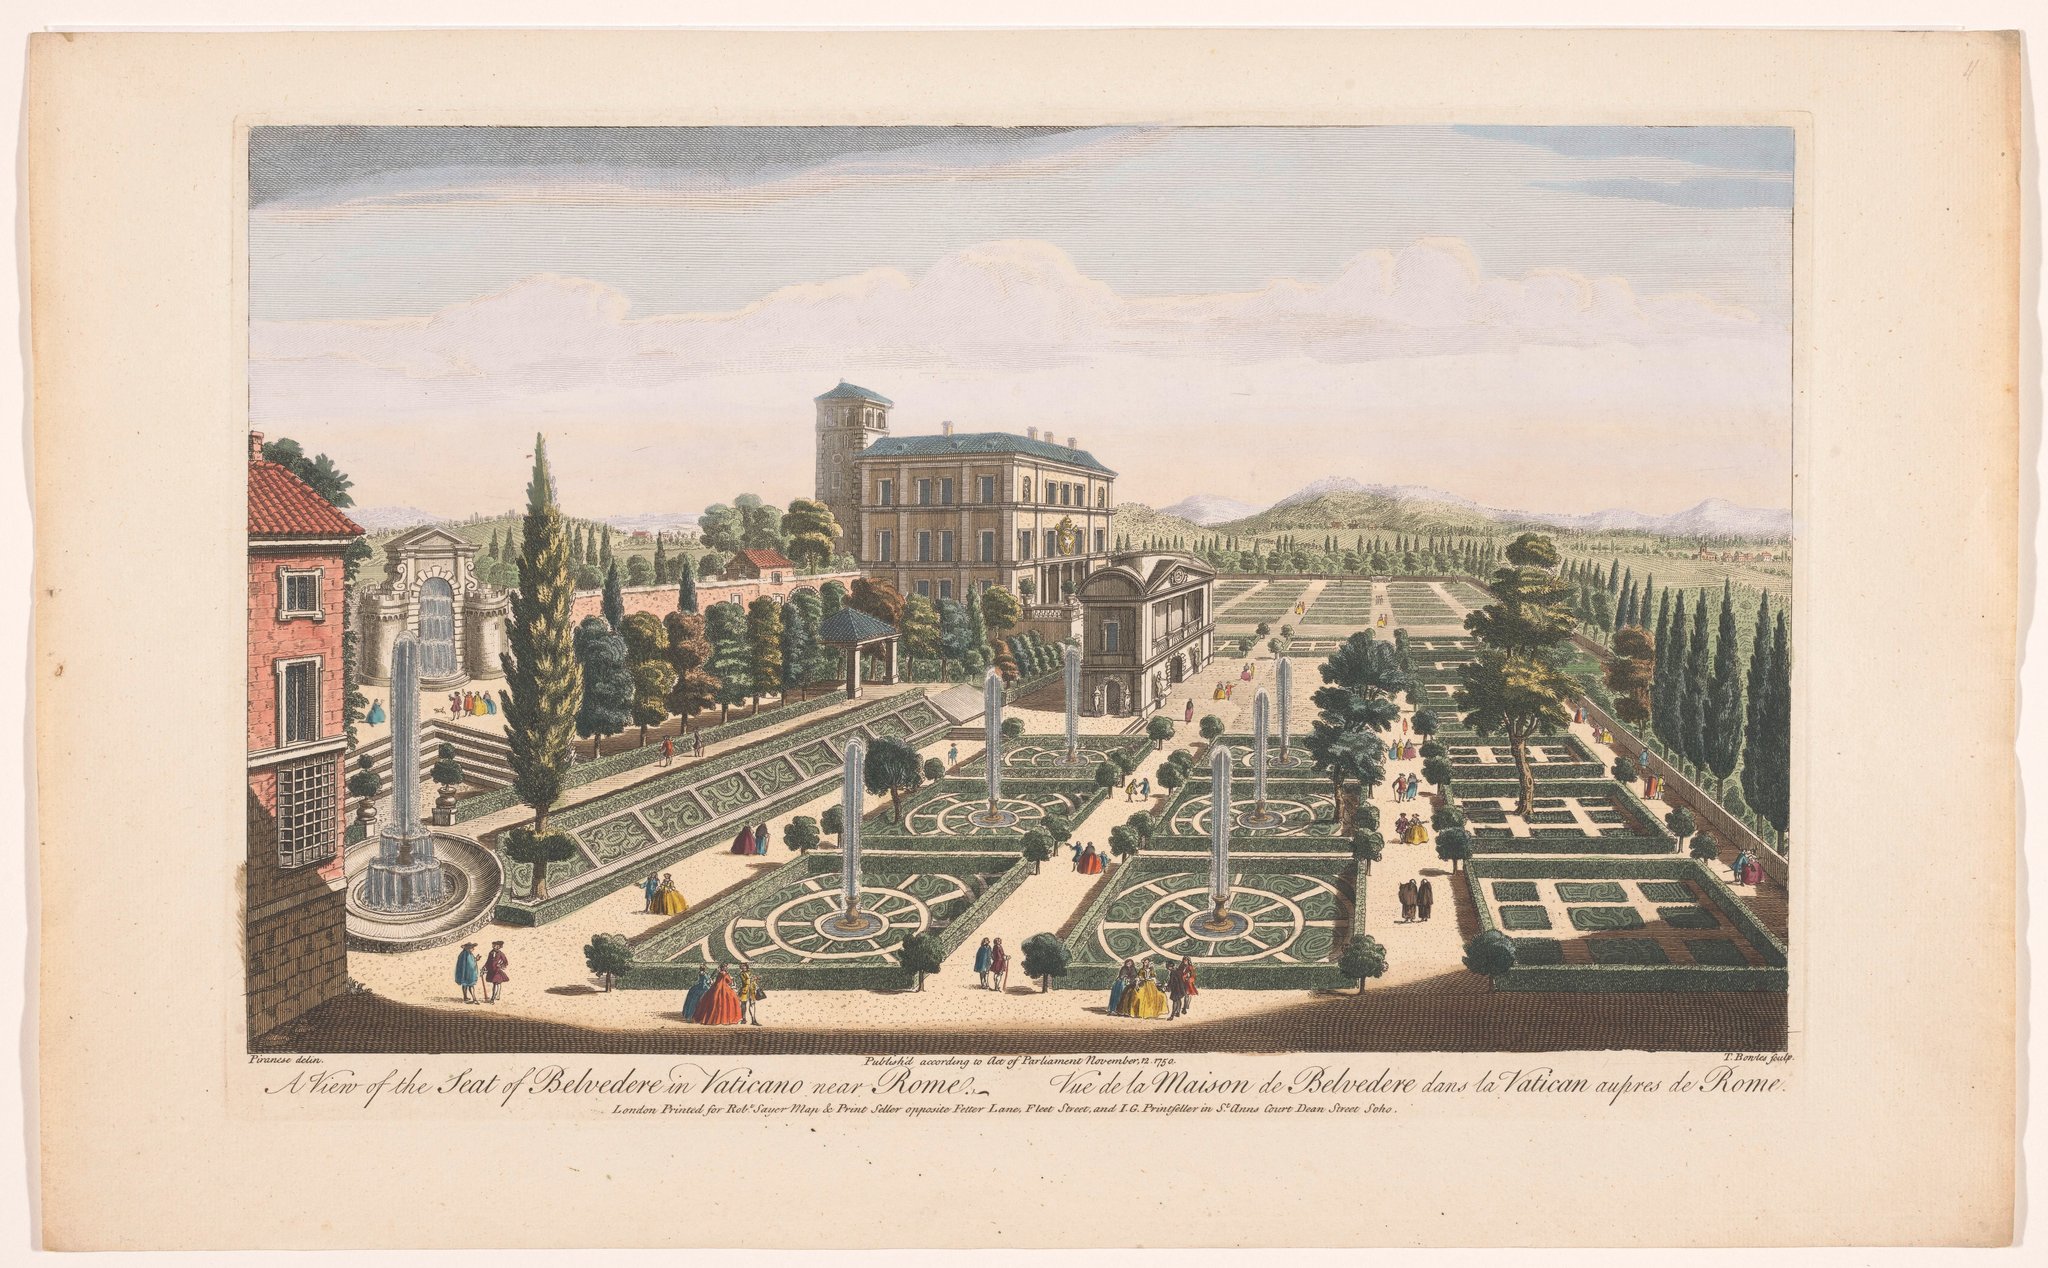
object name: print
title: Gezicht op de Giardini Vaticani te Vaticaanstad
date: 1750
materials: paper, watercolor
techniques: brush, etching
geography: london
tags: garden, garden fountain, ornamental plants, civic architecture; edifices; dwellings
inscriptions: date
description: Links de Fontana degli Specchi. In het midden het Casino di Pio IV. Op de voorgrond de Giardino de Semplici. Op de achtergrond links de Fontana delle Torri.